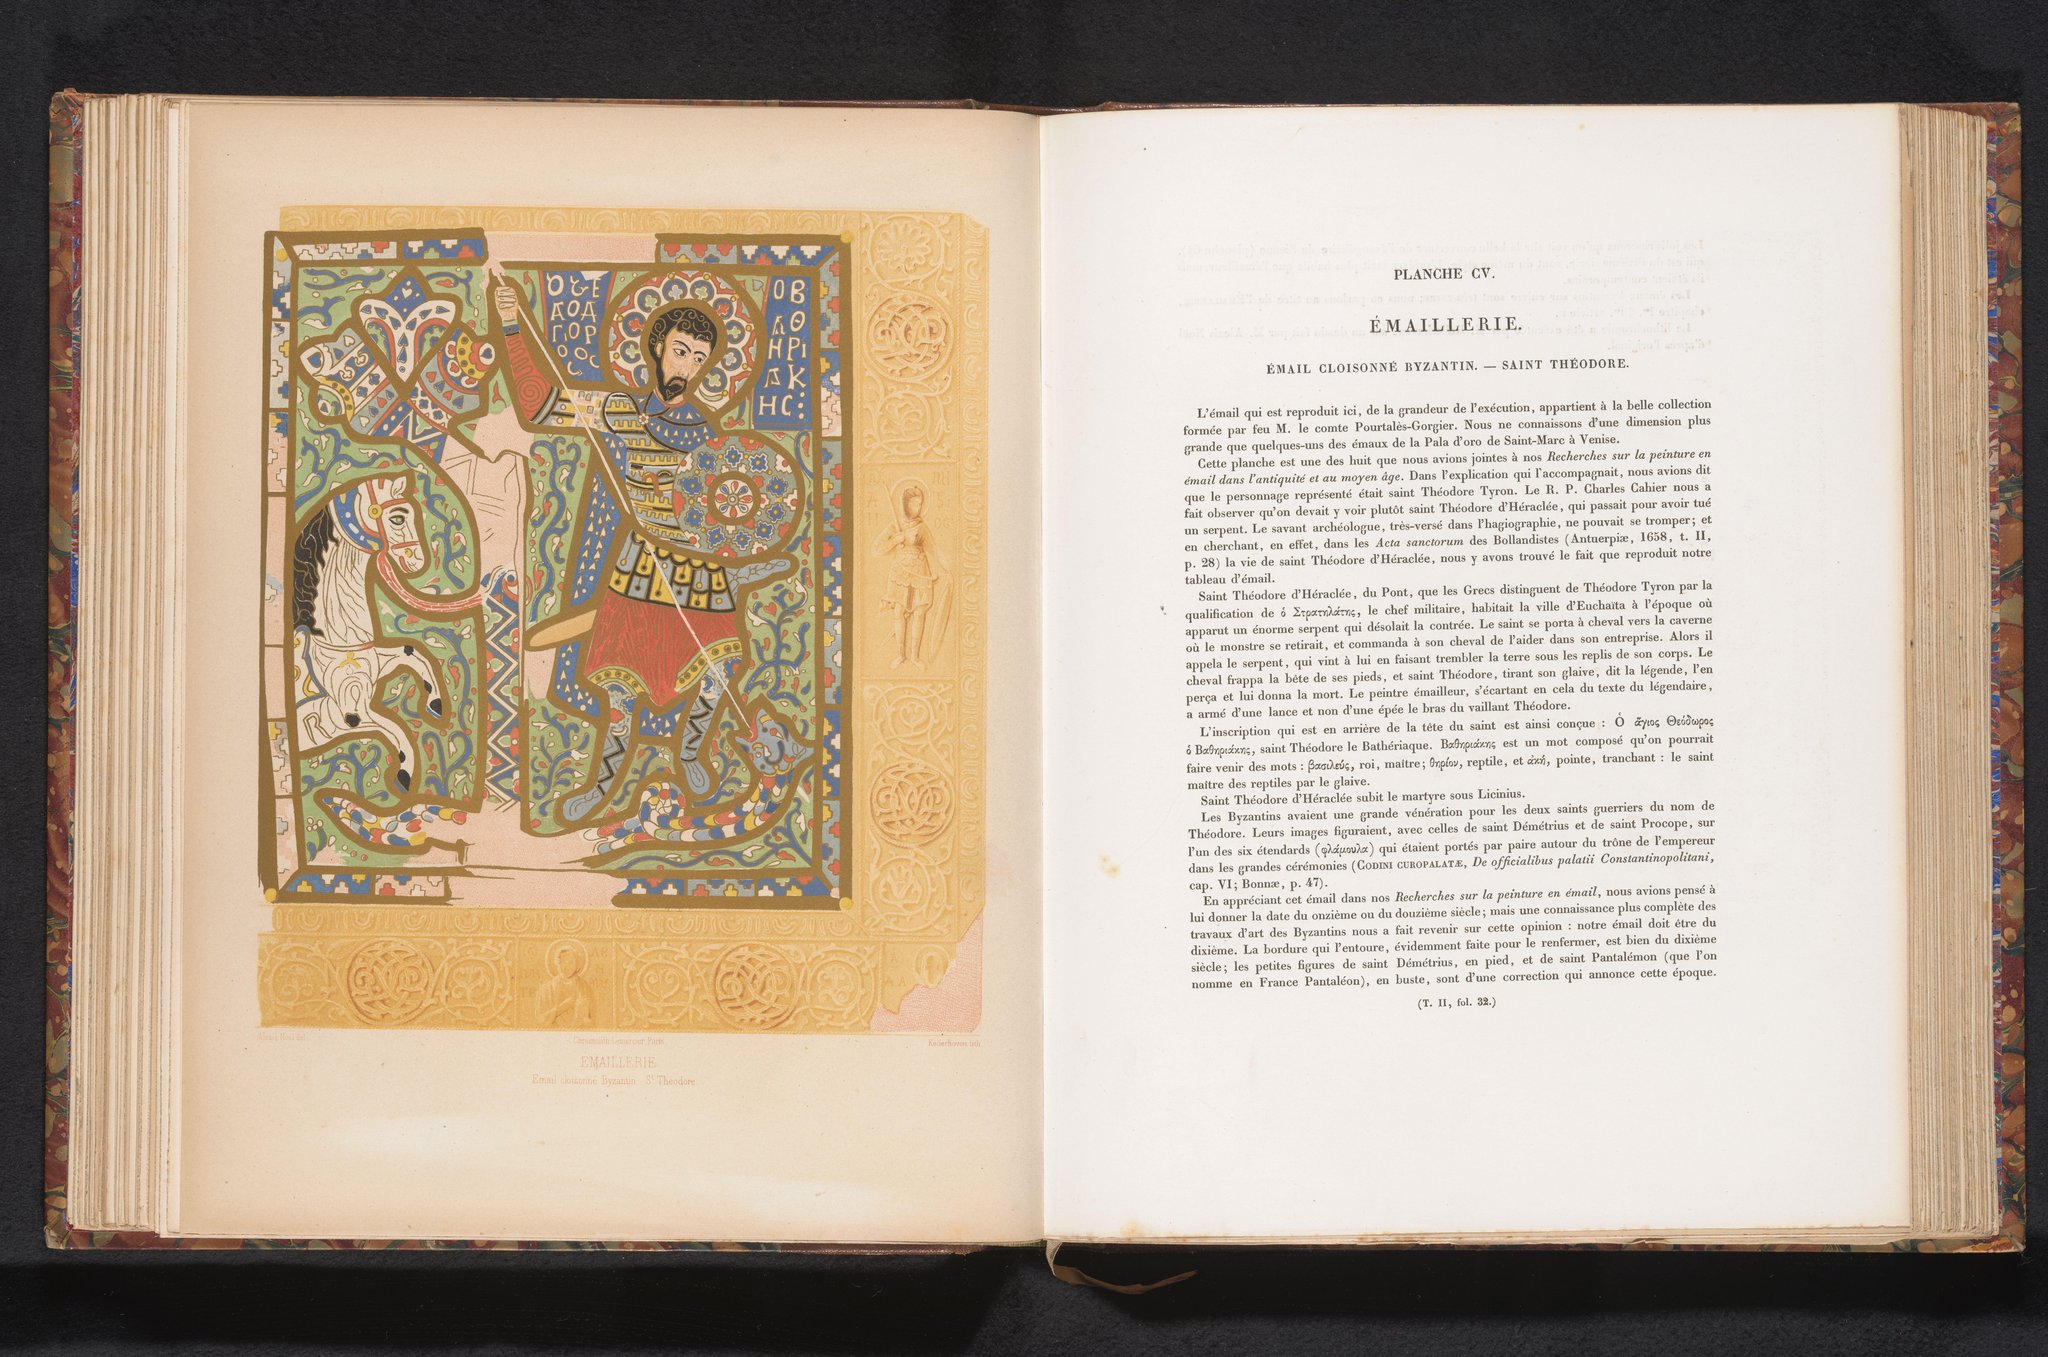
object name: reproduction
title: Reproductie van een ontwerp met de heilige Theodorus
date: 1859-1864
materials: paper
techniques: chromolithography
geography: paris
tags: the warrior martyr theodore tiro of echaïta (or amasea); possible attributes: banner, cuirass, dragon (or crocodile), lance, shield, sword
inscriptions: name: ‘Alexis Noël del./ Kellerhoven lith.’